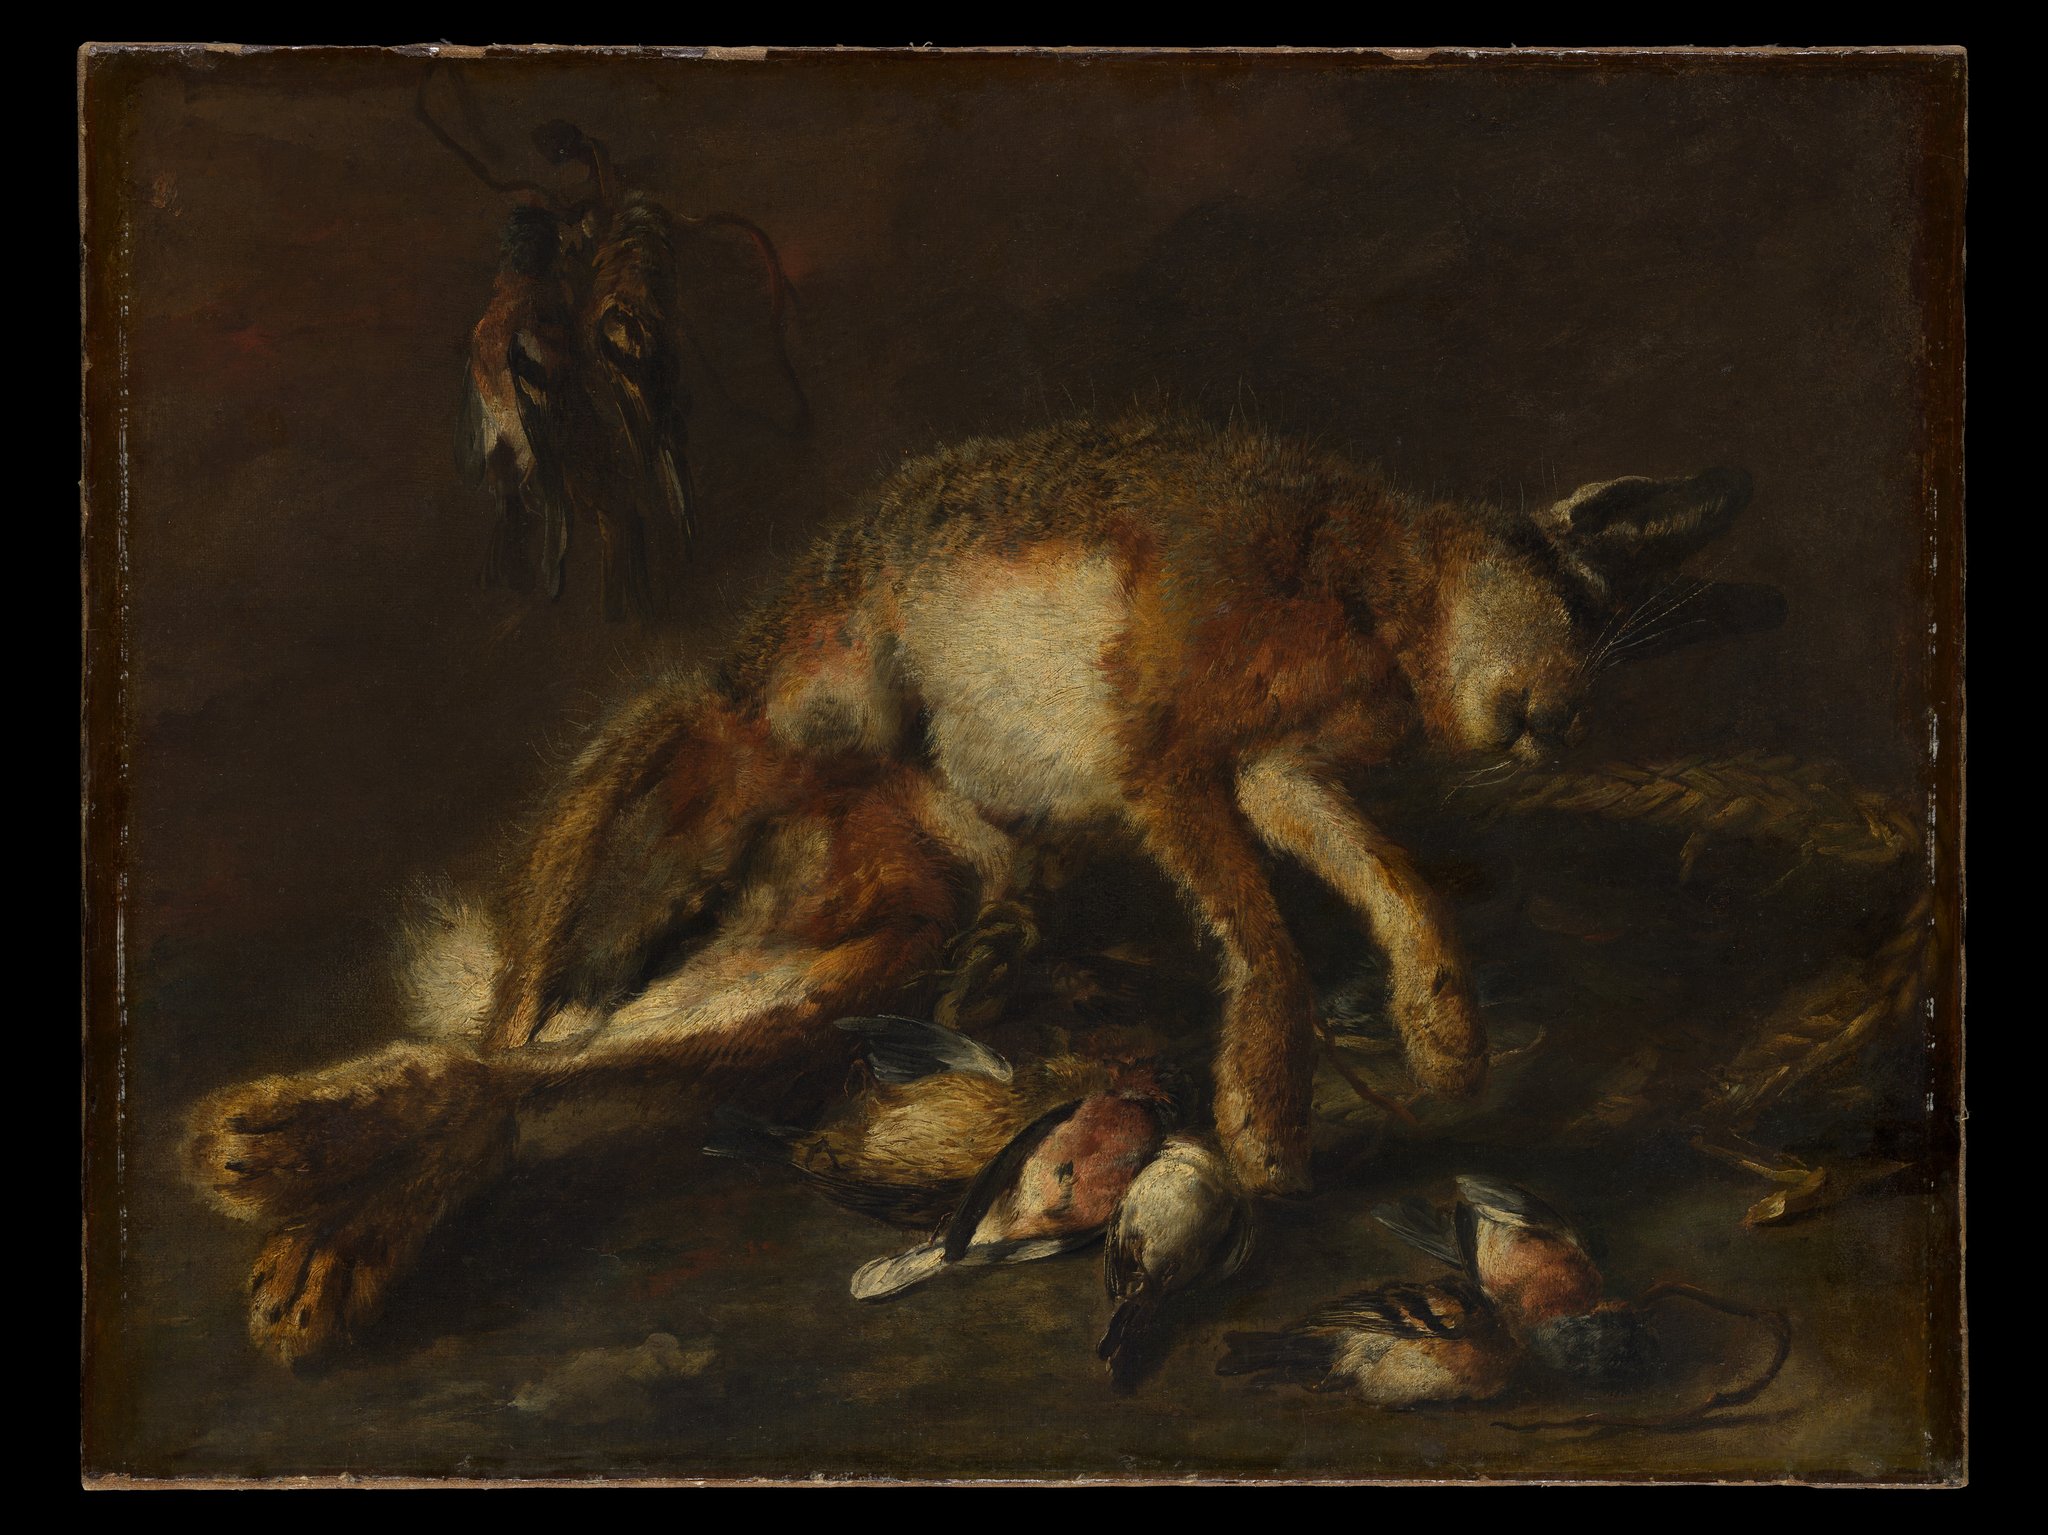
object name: painting, overdoor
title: A Hare and Birds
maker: jan fyt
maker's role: artist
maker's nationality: flemish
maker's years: 1611-1661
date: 1631-1661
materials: canvas, oil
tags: birds,rabbits,still life